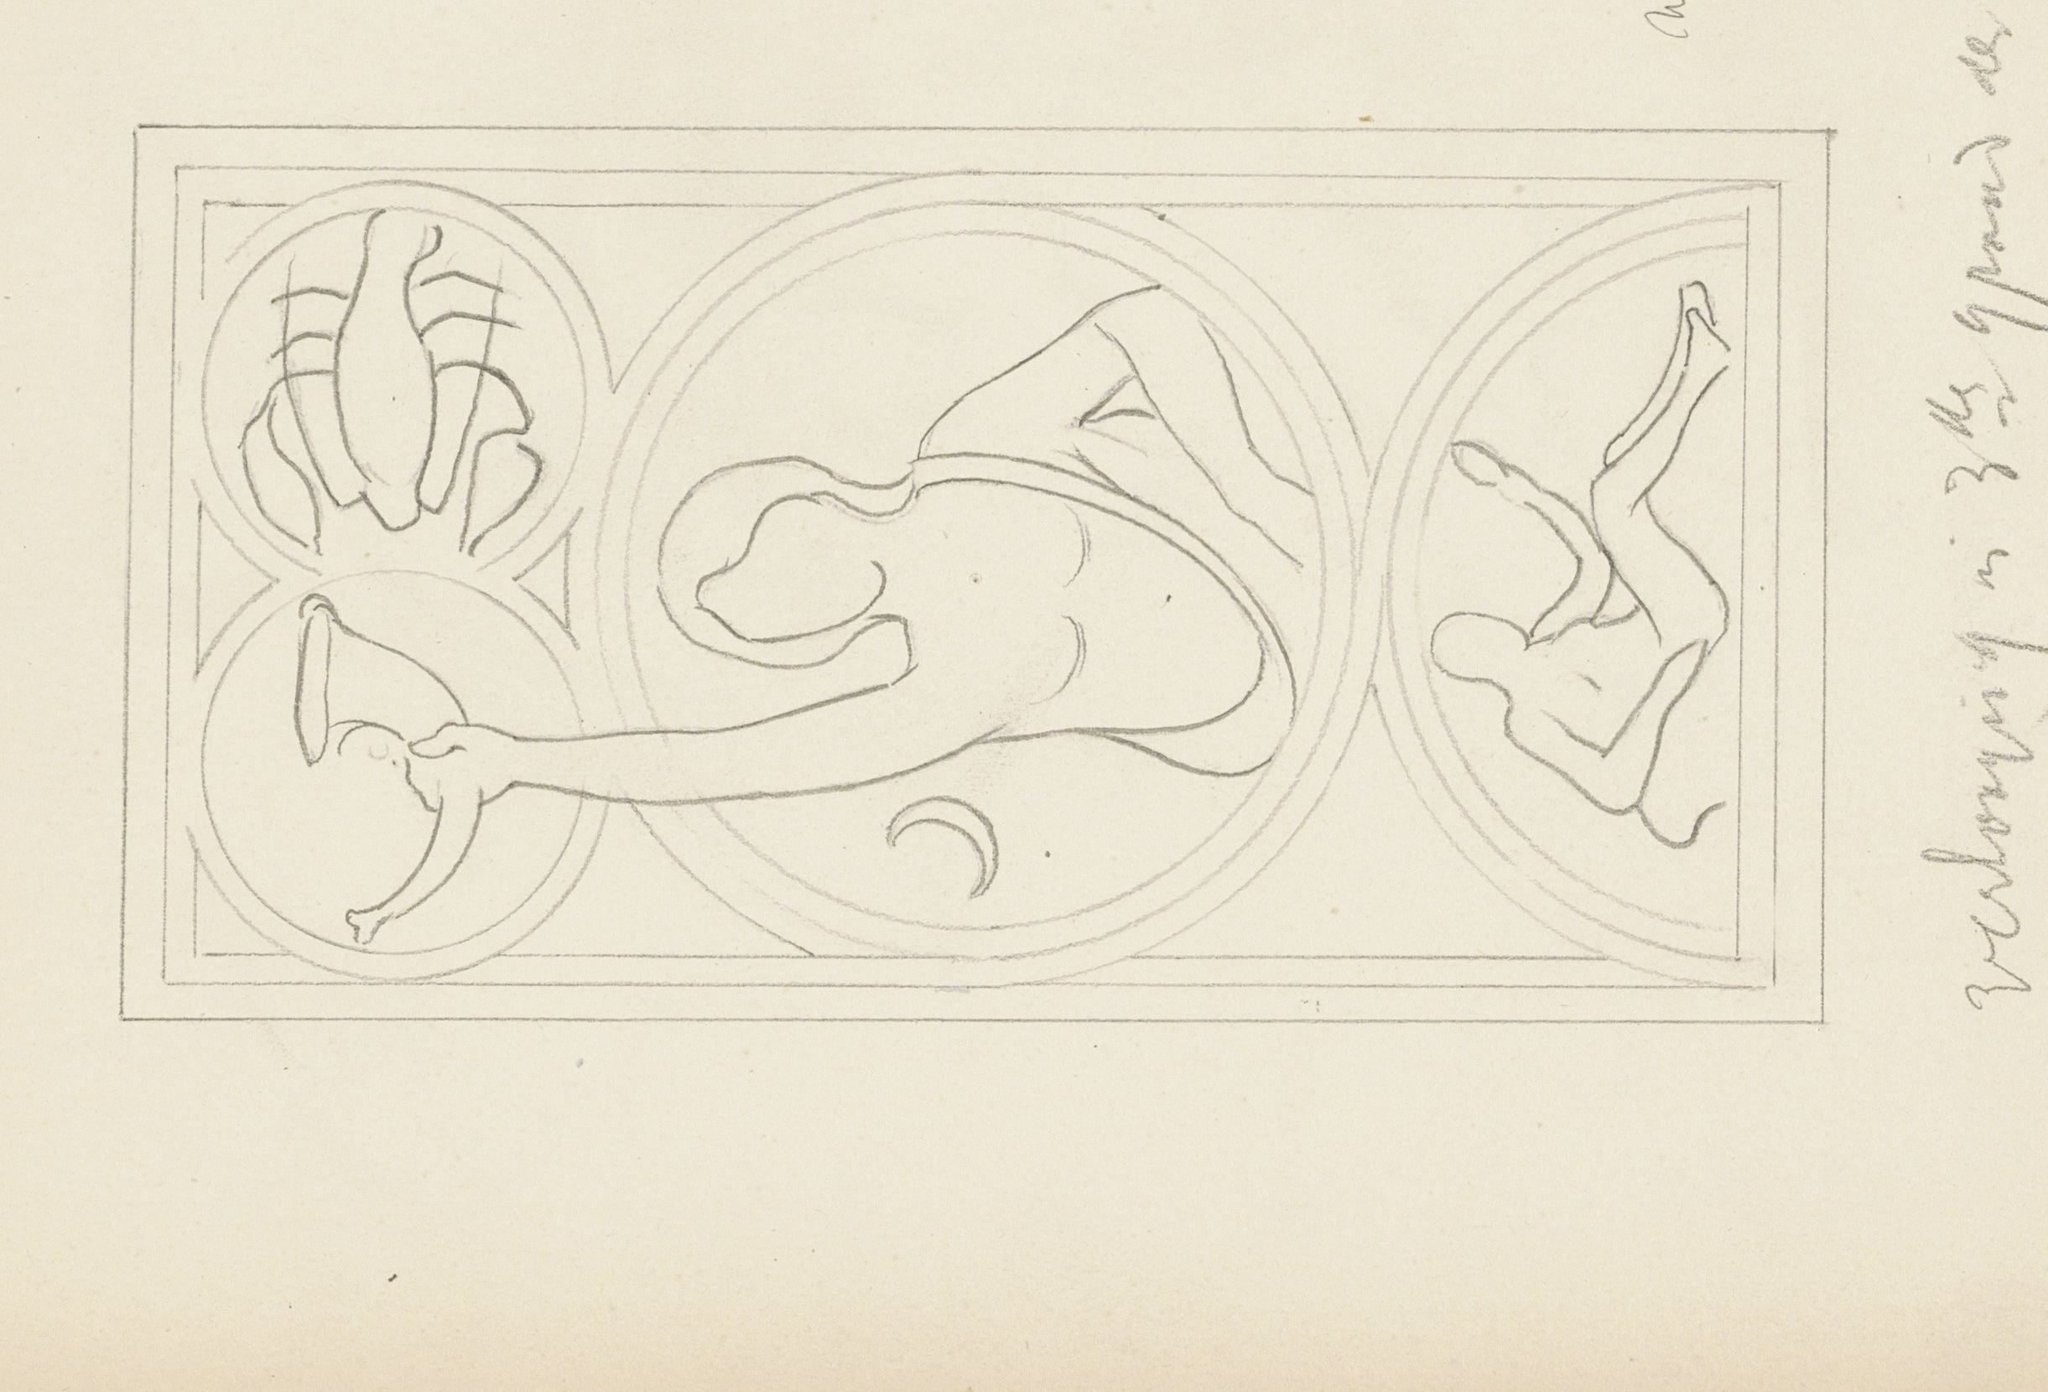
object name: sketchbook leaf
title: Personificatie van de Maan in een medaillon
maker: antoon derkinderen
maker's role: draughtsman, painter, print maker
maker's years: 1859-1925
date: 1900-1903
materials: paper, pencil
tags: cancer (zodiacal sign of june), diana as moon-goddess, i.e. luna (selene), hunting horn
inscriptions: annotation: ‘n[...]igheid/ verhooging in 3 de grand de Hier[...]’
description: Luna, de Maan, heft een jachthoorn op. Op de achtergrond een maansikkel. Boven het medaillon een kleiner medaillon met een voorstelling van het sterrenbeeld kreeft. Eronder een half medaillon met een voorstelling van een zittende figuur met een spiegel in de hand. Ontwerp voor een glas-in-loodraam voor de Kamer van Koophandel in de Beurs van Berlage te Amsterdam. Blad 12 recto uit een schetsboek met 45 bladen.